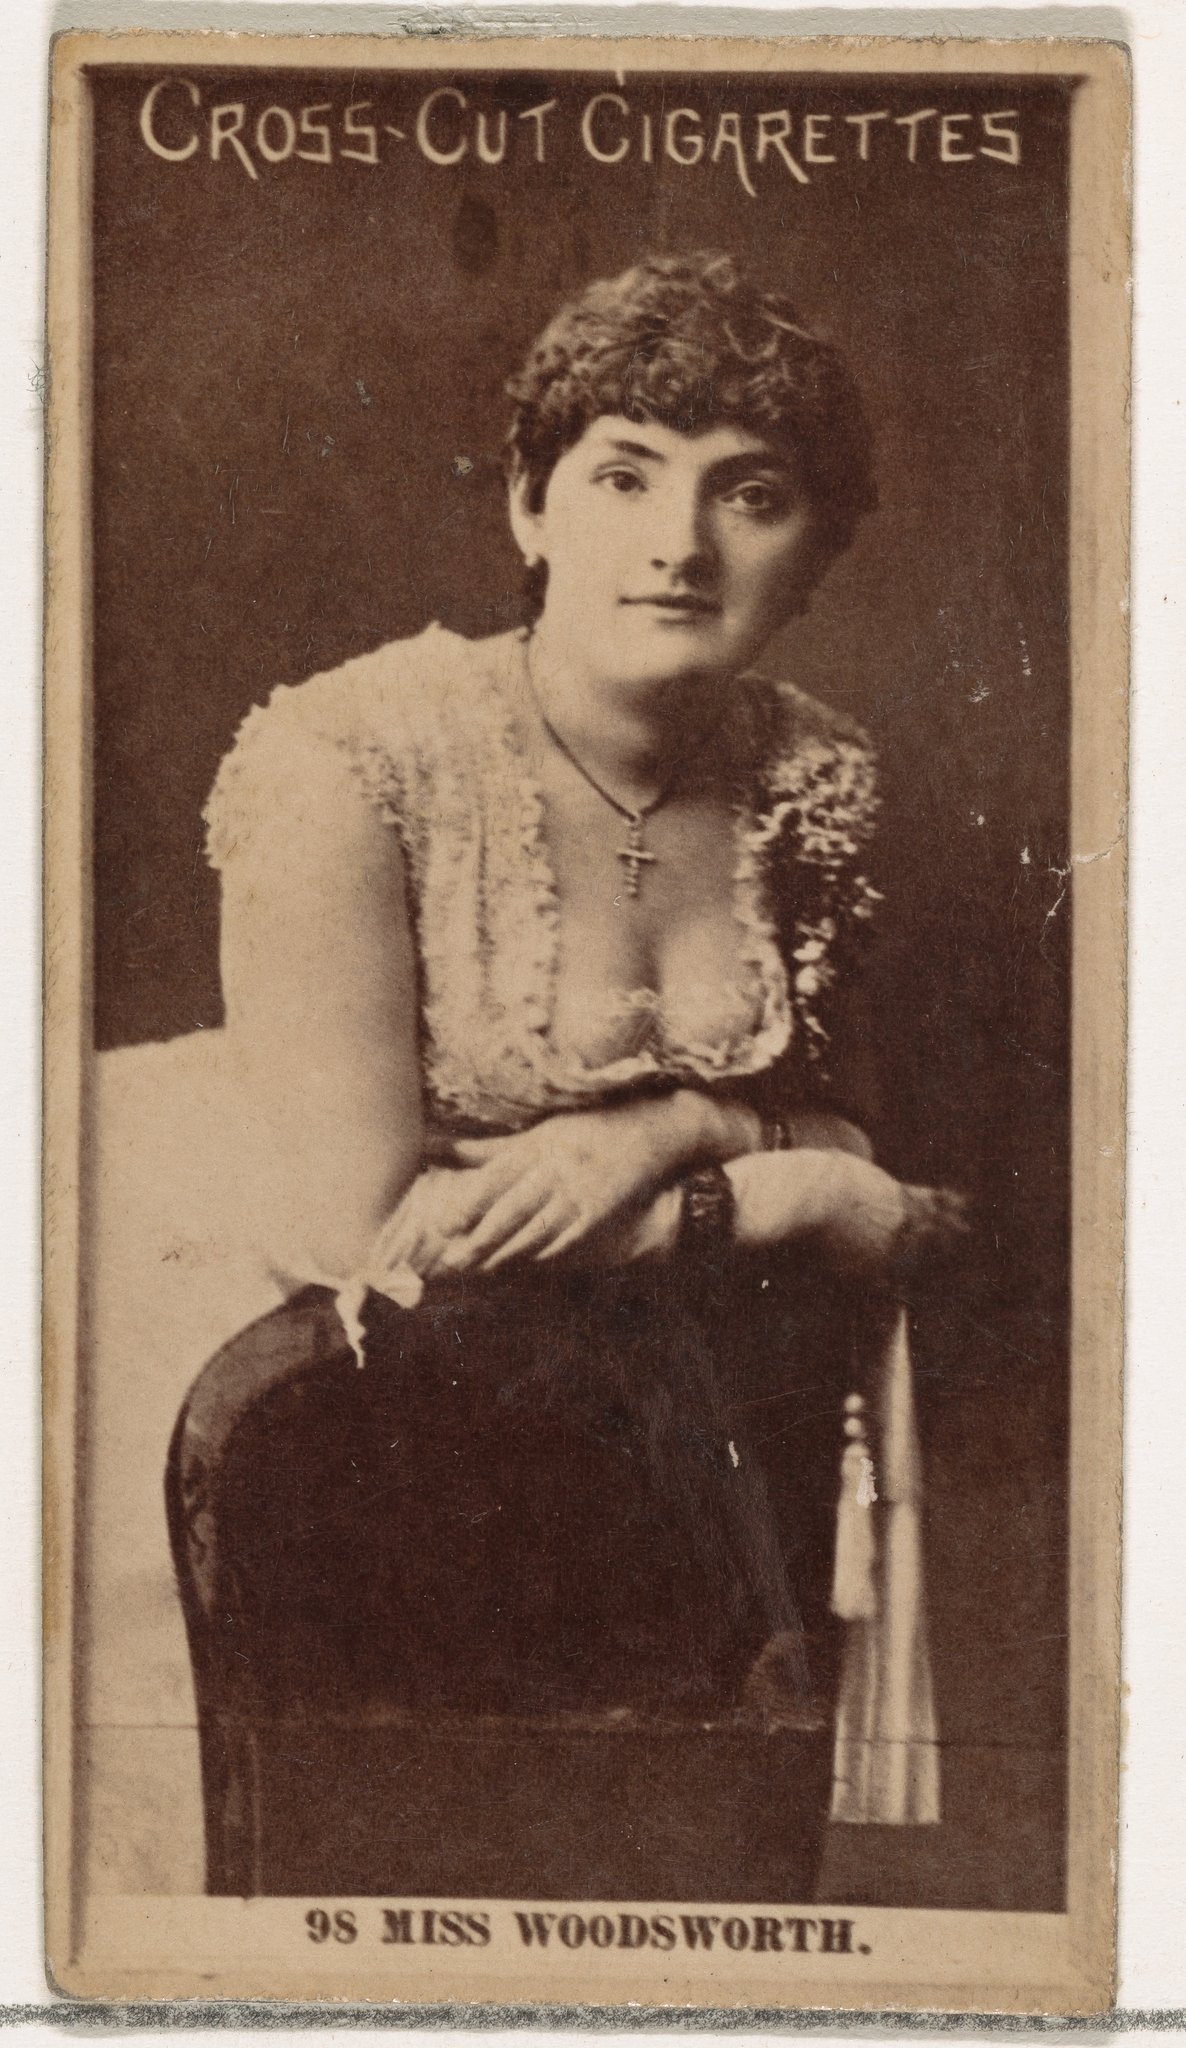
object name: print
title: Card Number 98, Miss Woodsworth, from the Actors and Actresses series (N145-2) issued by Duke Sons & Co. to promote Cross Cut Cigarettes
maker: w. duke, sons & co.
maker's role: publisher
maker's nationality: american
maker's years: 1870-1920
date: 1880-1889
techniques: albumen silver print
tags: portraits,women,actresses